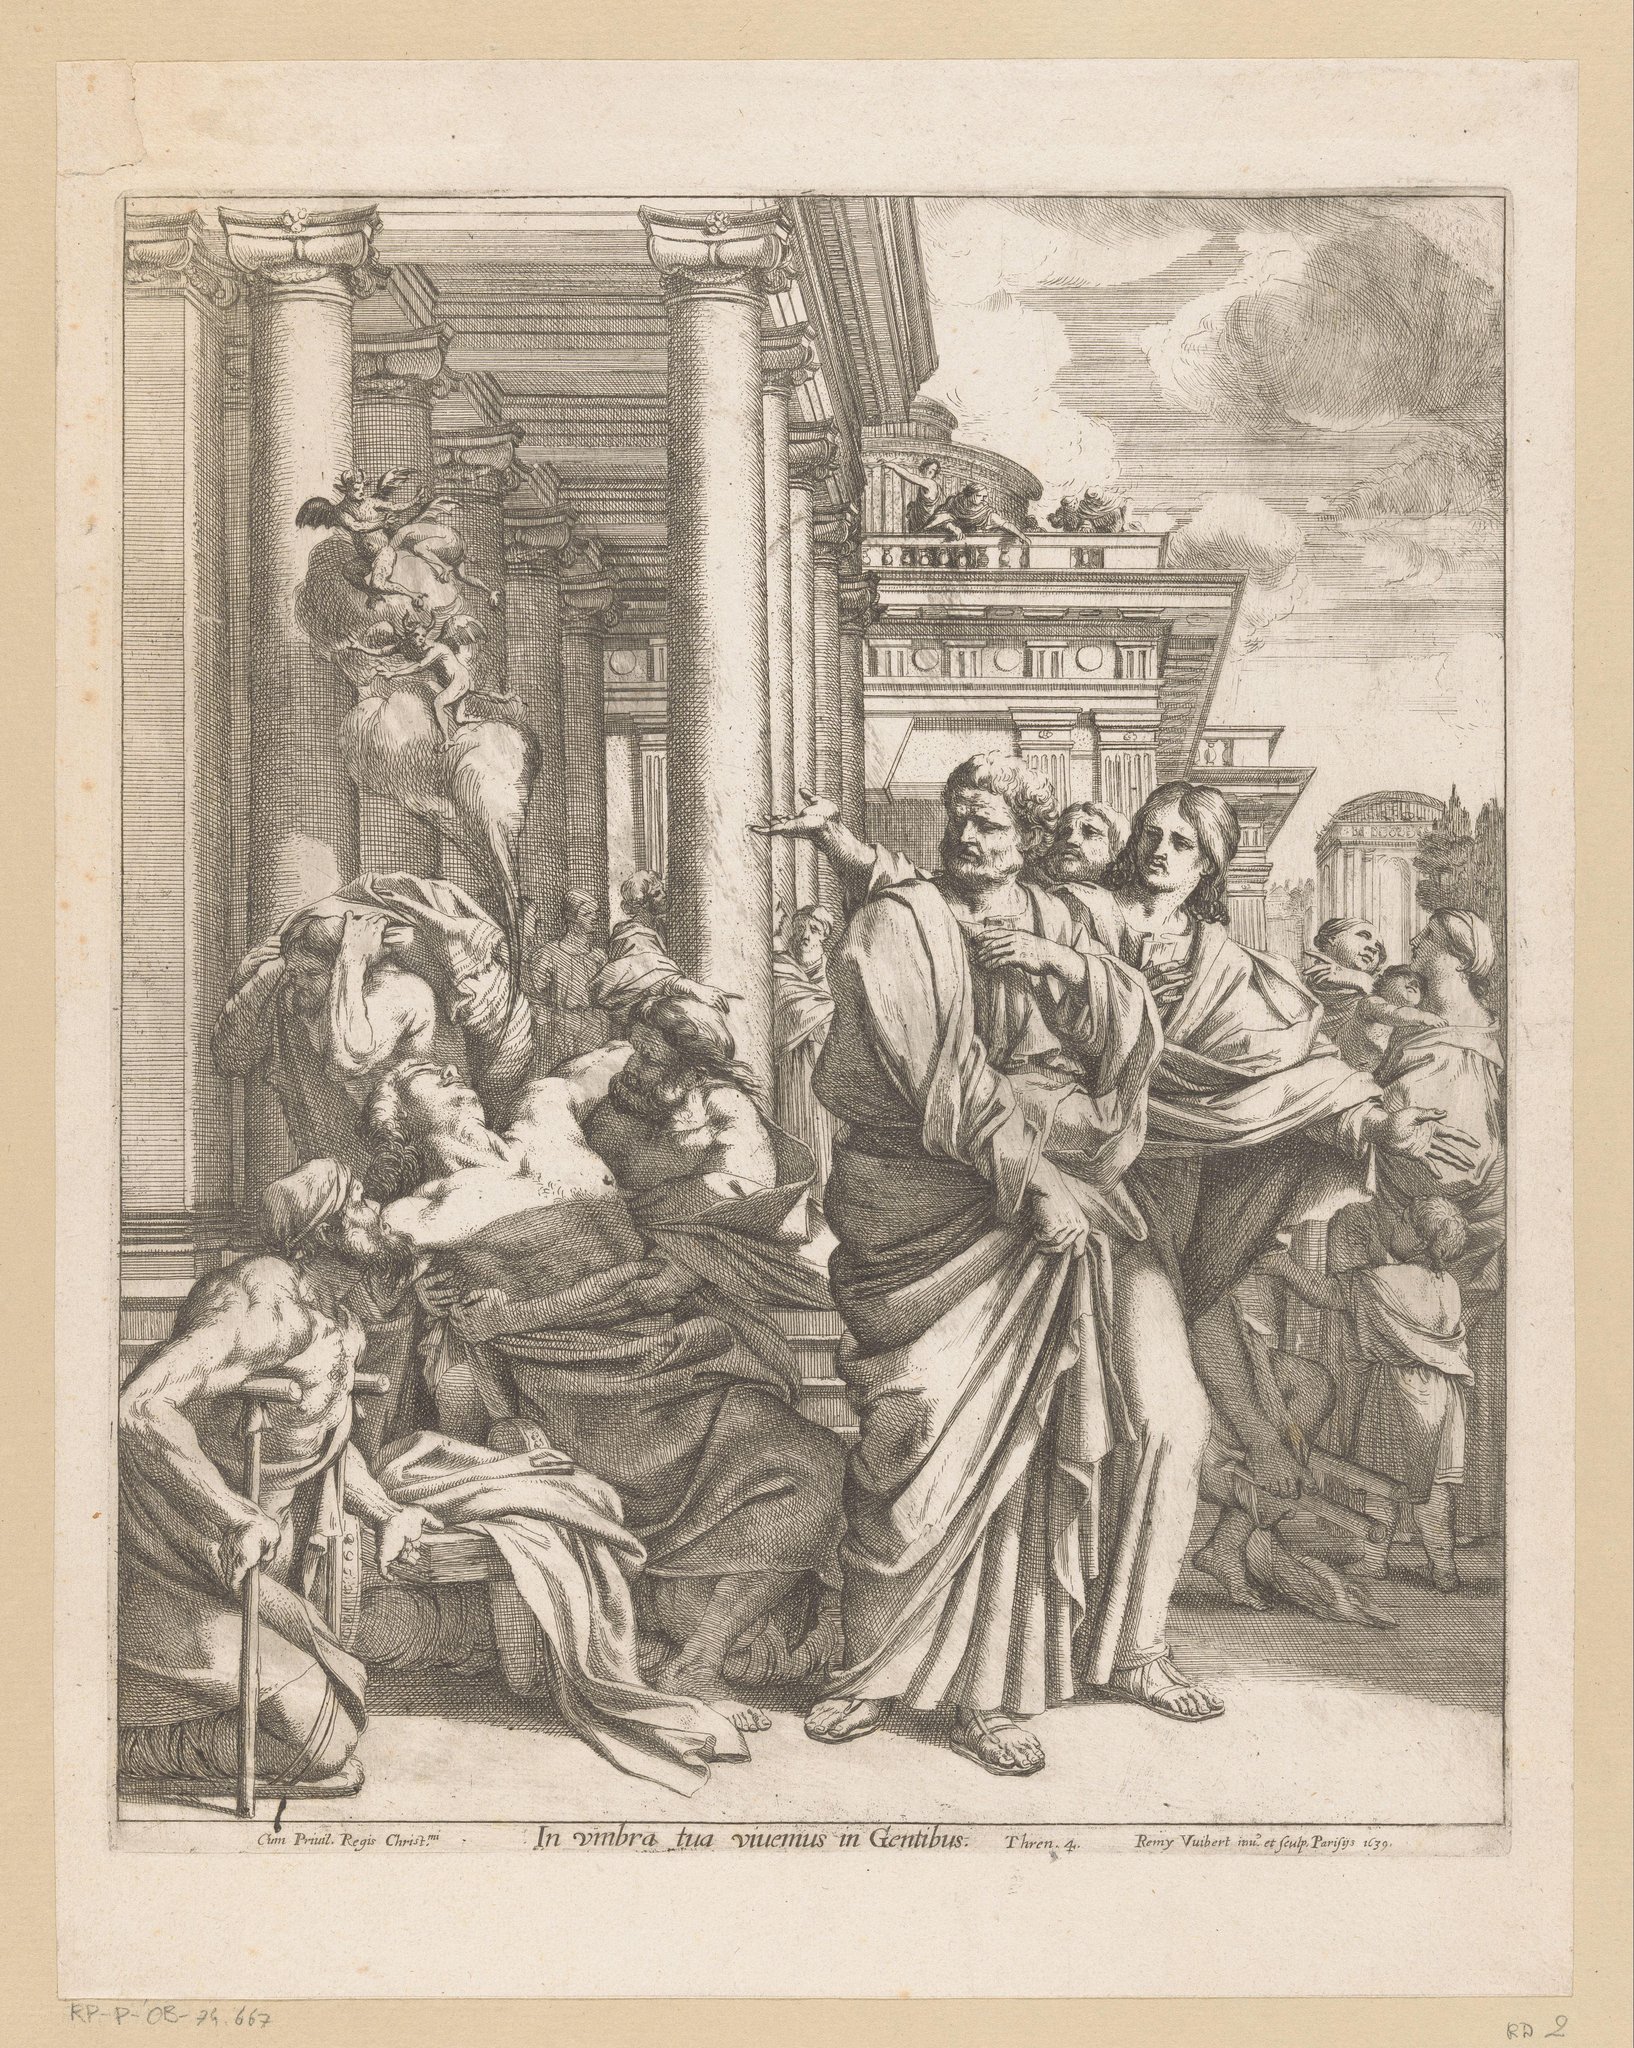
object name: print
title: Paulus wekt Eutychus terug tot leven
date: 1639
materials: paper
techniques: etching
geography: paris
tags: a multitude of the sick healed by peter and other disciples (acts 5:12-16), sick people brought into the streets, so that peter's shadow might fall on them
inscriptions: collector's mark: Lugt 240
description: Petrus geneest zieken en bezetenen en met zijn schaduw (Handelingen 5:15-16). Het onderschrift in afkomstig uit Klaagliederen 4:20.